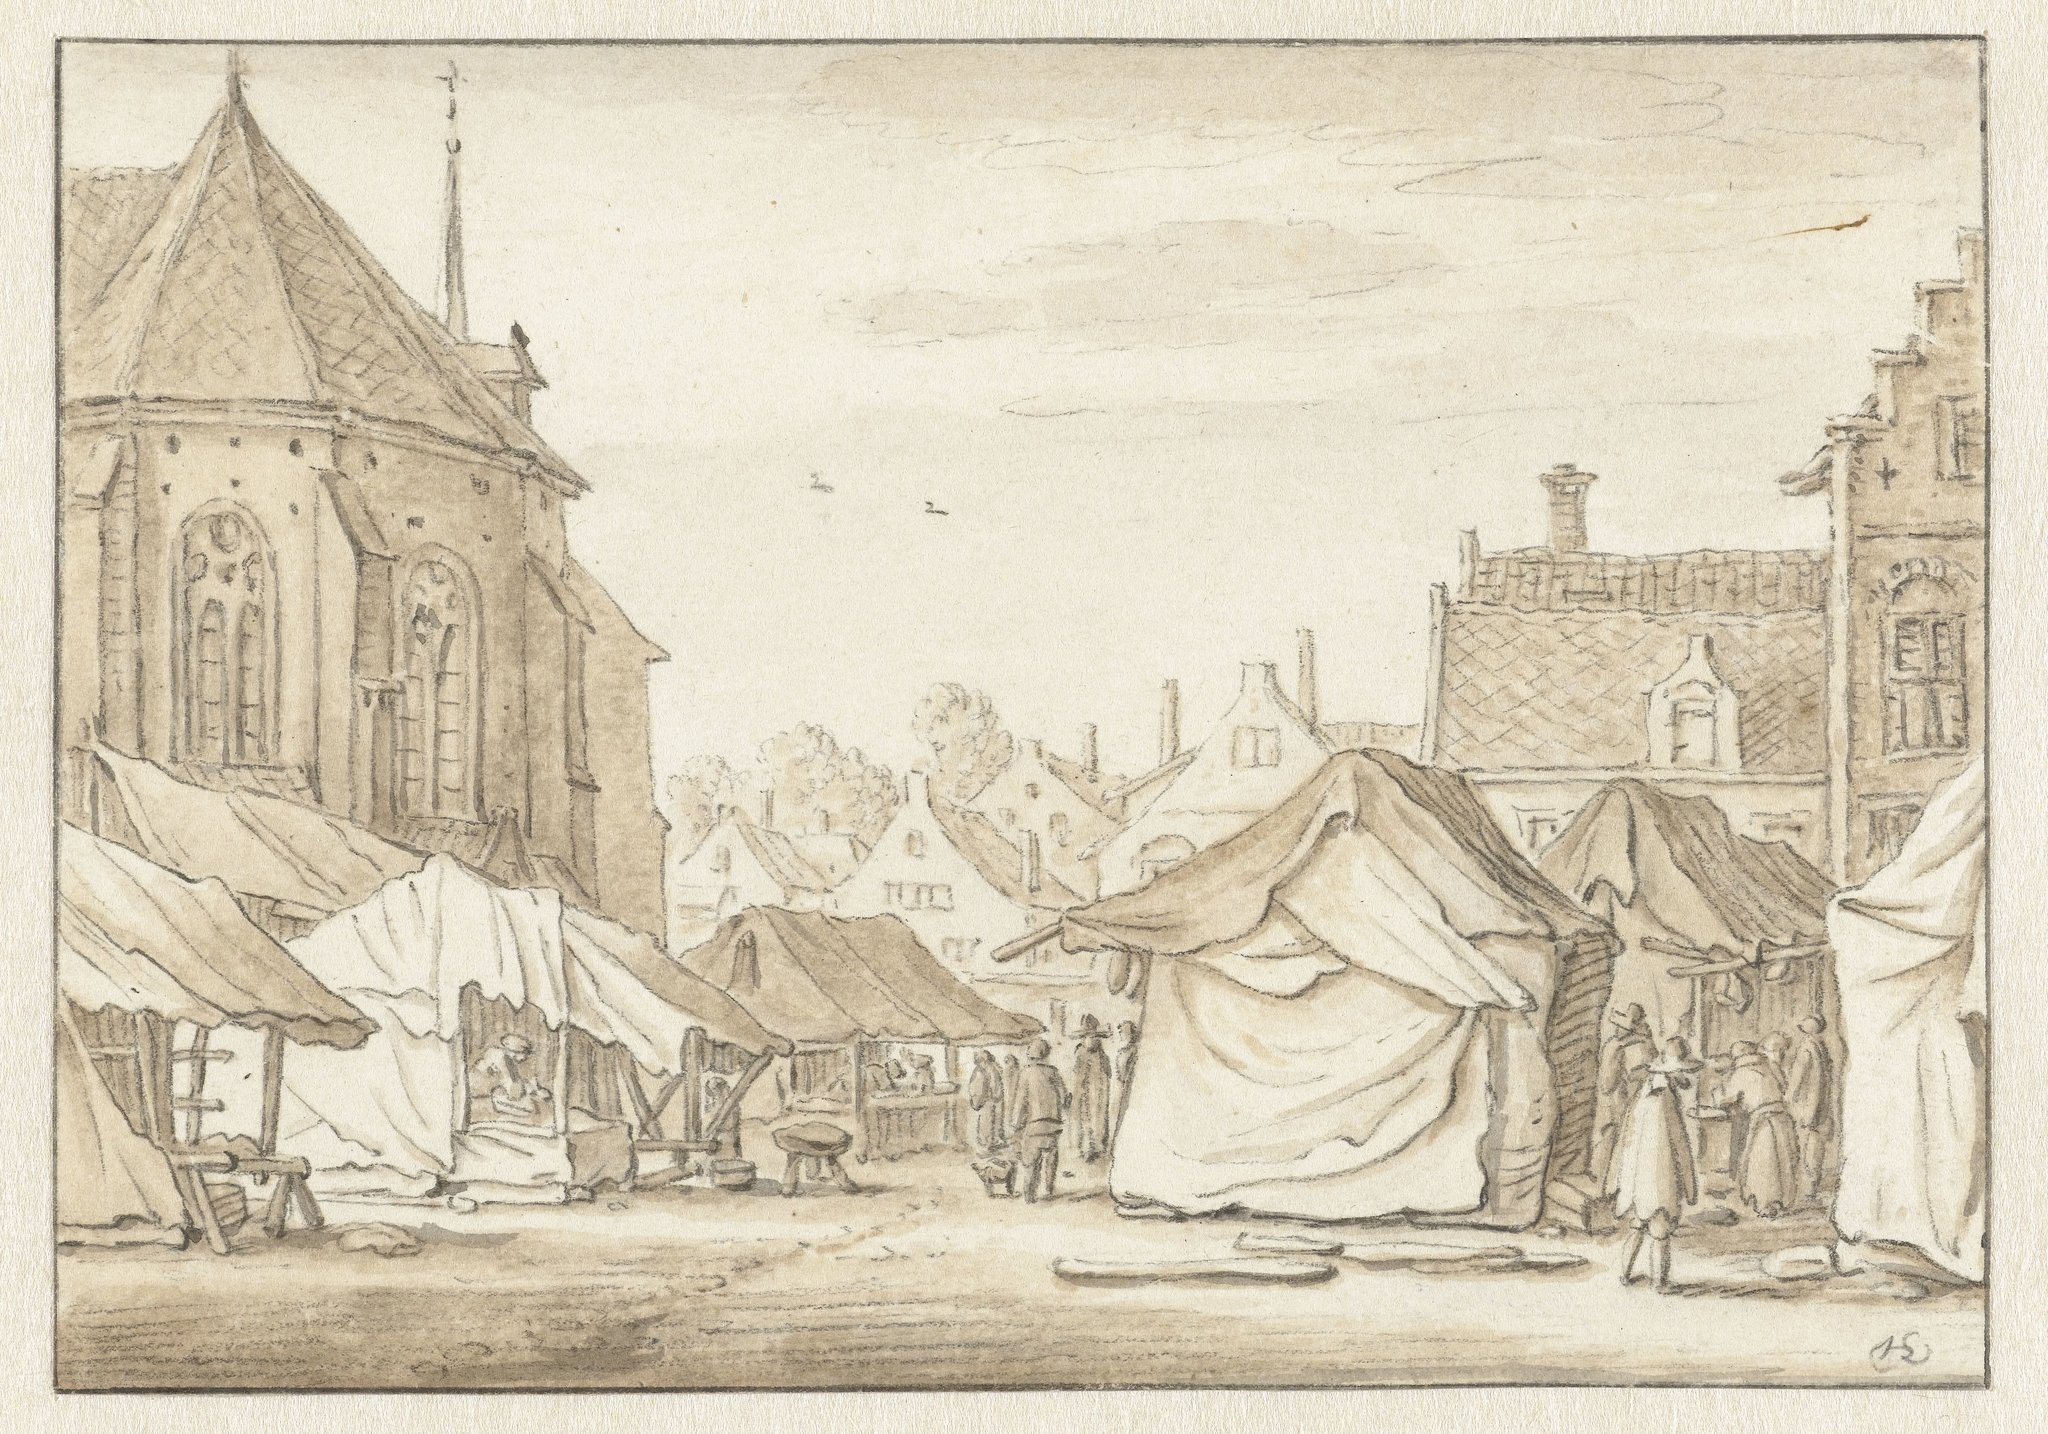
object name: drawing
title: Markt op de Mariaplaats te Utrecht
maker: herman saftleven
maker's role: draughtsman, painter, print maker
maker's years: 1609-1685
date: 1619-1685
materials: chalk, paper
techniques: brush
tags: square, place, circus, etc., market, utrecht